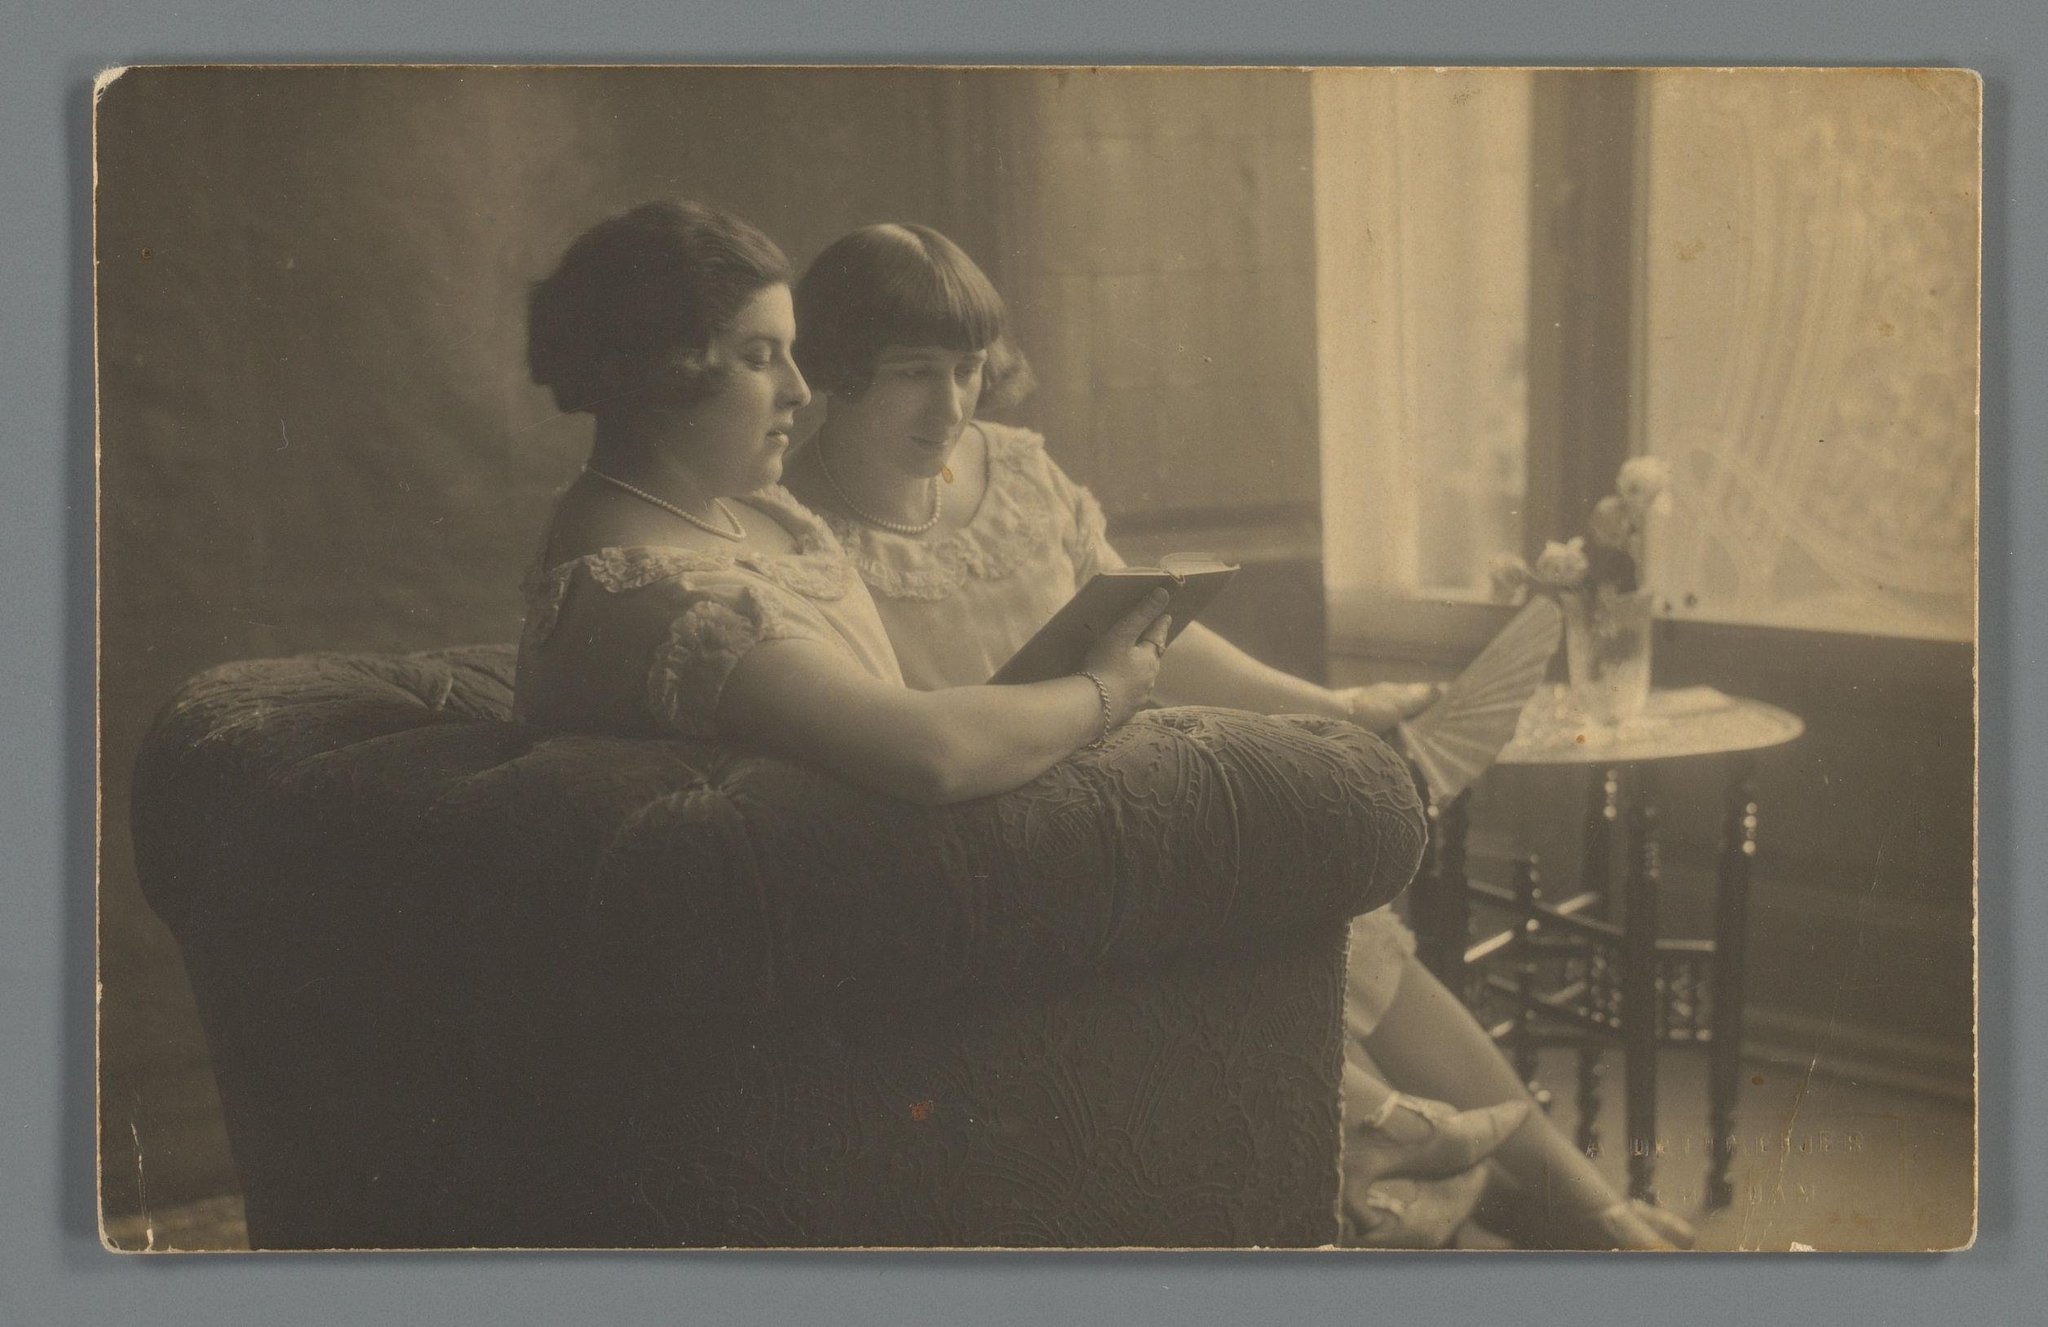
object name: photograph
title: Portret van Henny en Cato Merks lezend op de bank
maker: arie dettmeijer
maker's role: fotograaf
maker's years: 1884-1967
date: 1918-1926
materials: paper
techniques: gelatin silver print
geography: schiedam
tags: reading, historical persons - bb - woman, portrait of cabaret-artiste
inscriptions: inscription: ‘Henny en Cato/ Merks’, stamp: ‘Dettmeijer's Fotoatelier/ Goudsche Singel 219/ Rotterdam’, check stamp: ‘A. Dettmeijer/ Schiedam’